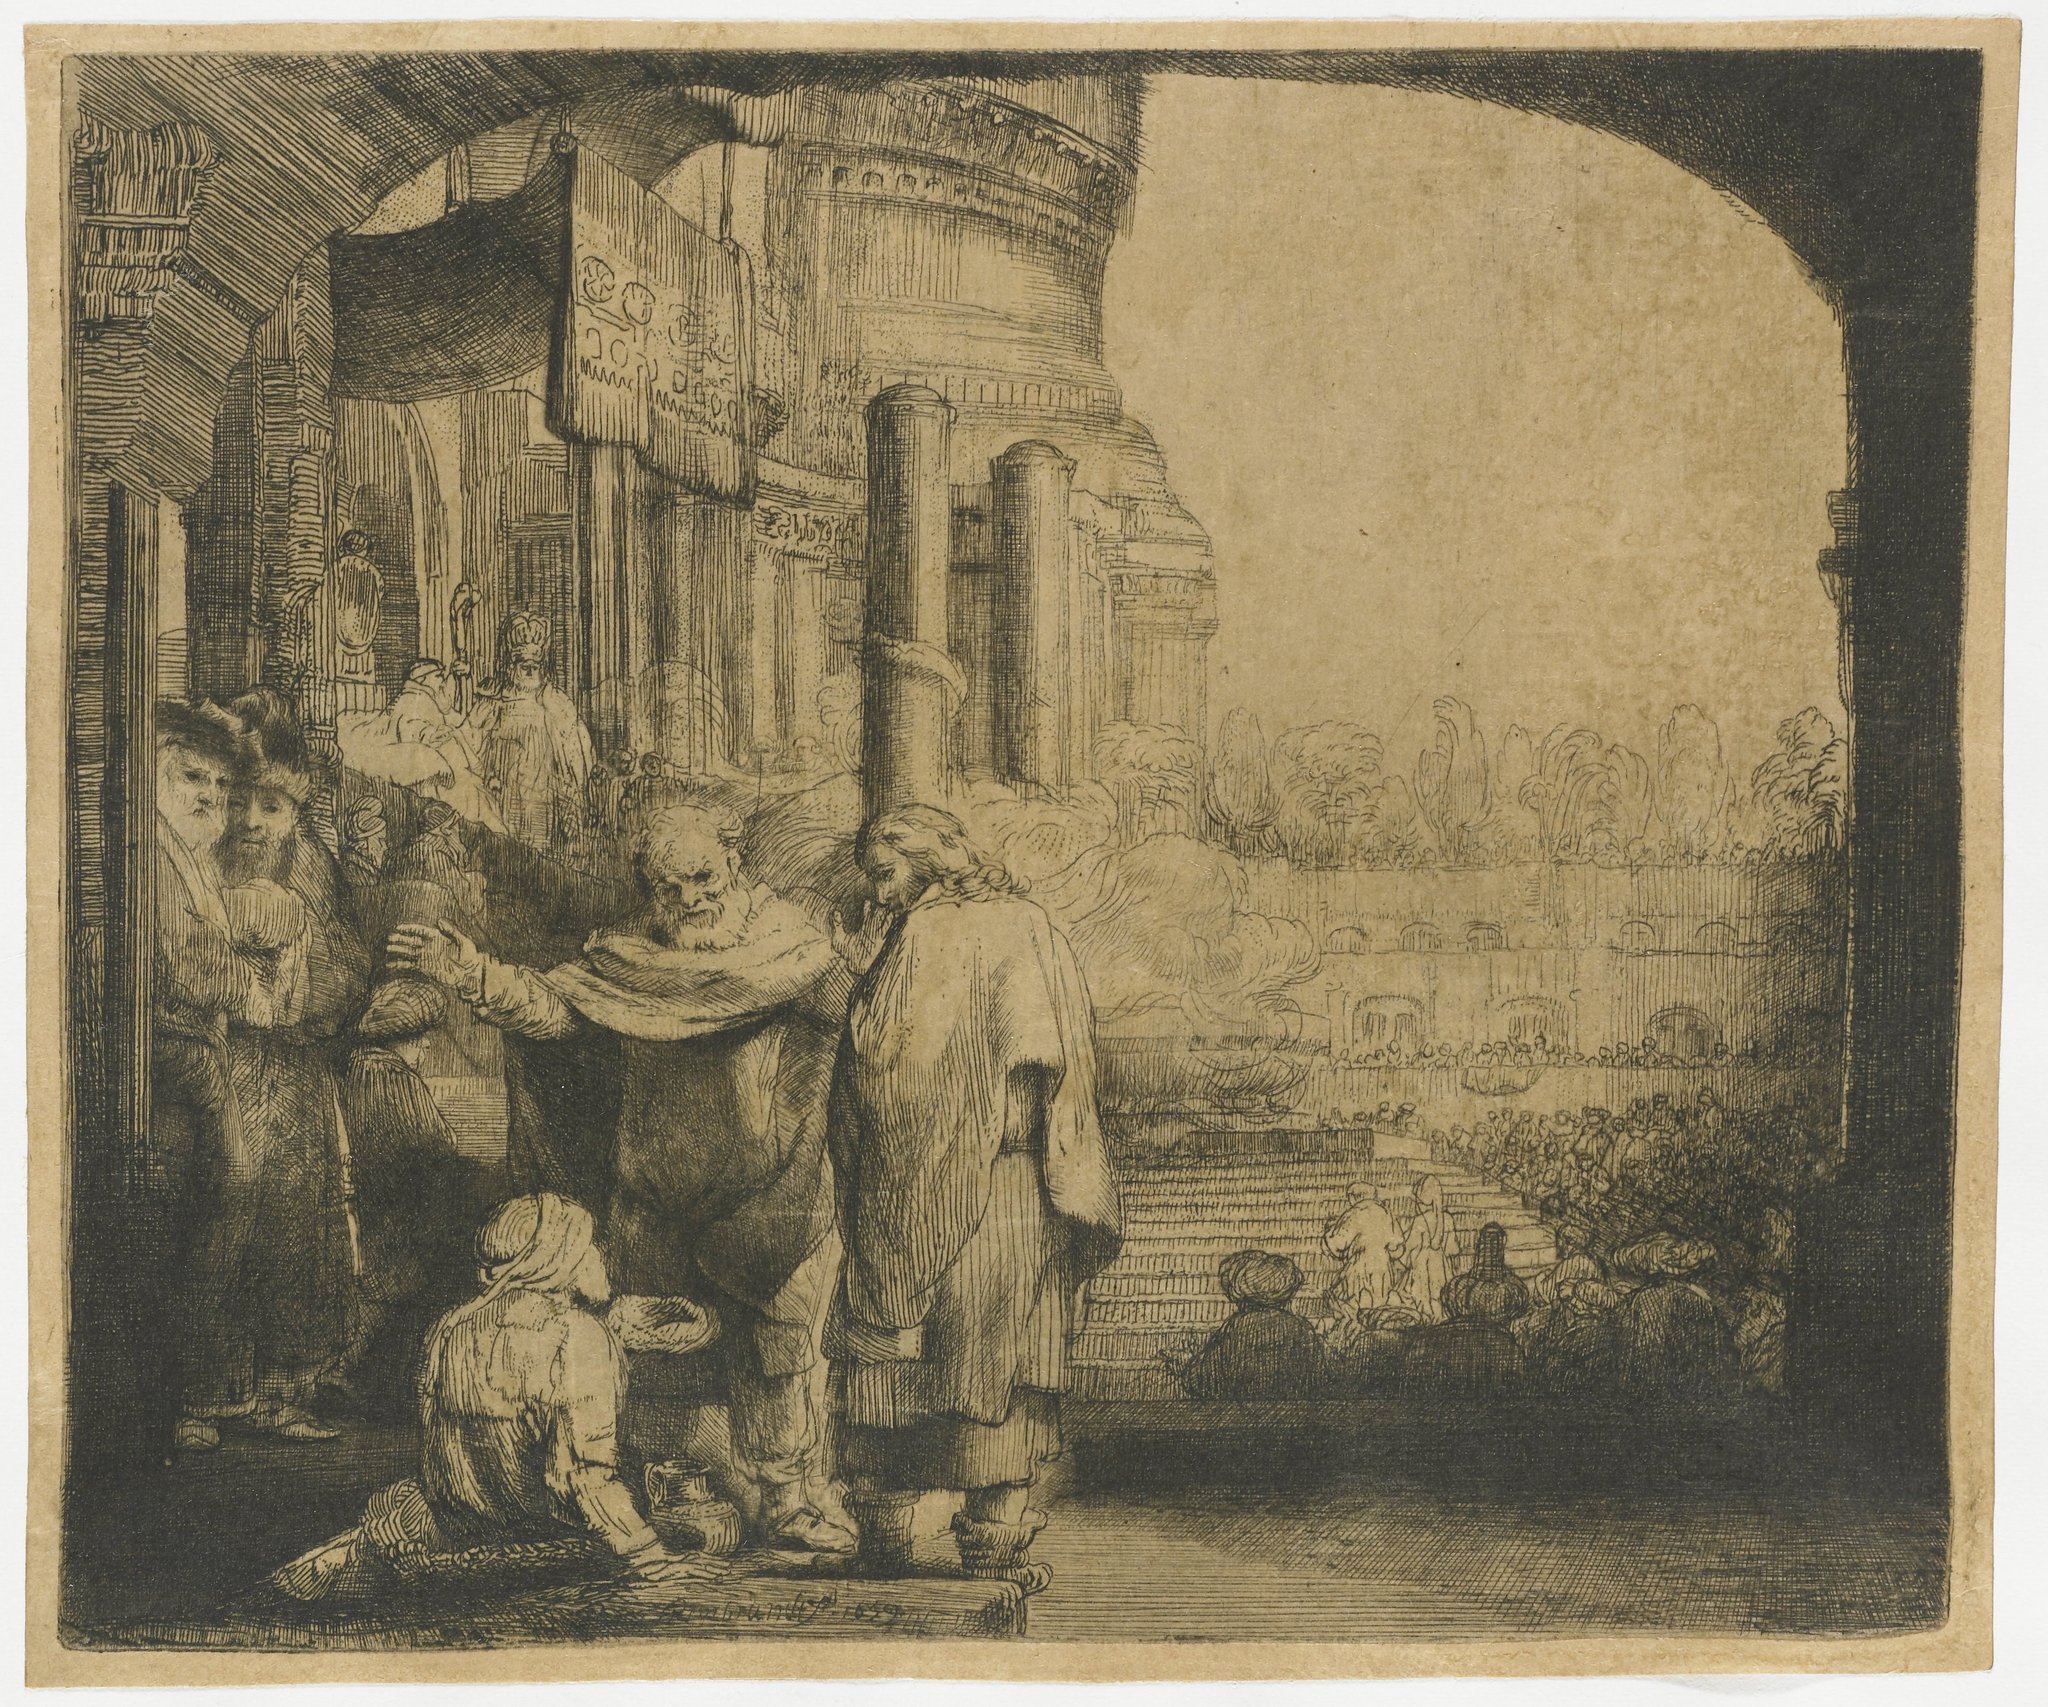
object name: print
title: Peter and John healing the cripple at the gate of the temple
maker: rembrandt van rijn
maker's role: draughtsman, painter, print maker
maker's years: 1606-1669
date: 1659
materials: paper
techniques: drypoint, etching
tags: healing of a lame beggar at the beautiful gate of the temple by peter and john (acts 3 - 4:31), disabilities, deformations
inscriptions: inscription: ‘48 St’, signature and date: ‘Rembrandt f. 1659’, collector's mark: Lugt 240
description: De voorstelling is gebaseerd op de tekst uit Handelingen 3:4-31.